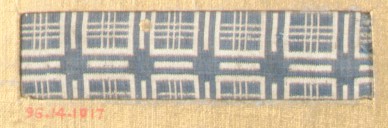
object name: piece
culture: japanese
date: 1701-1900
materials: silk